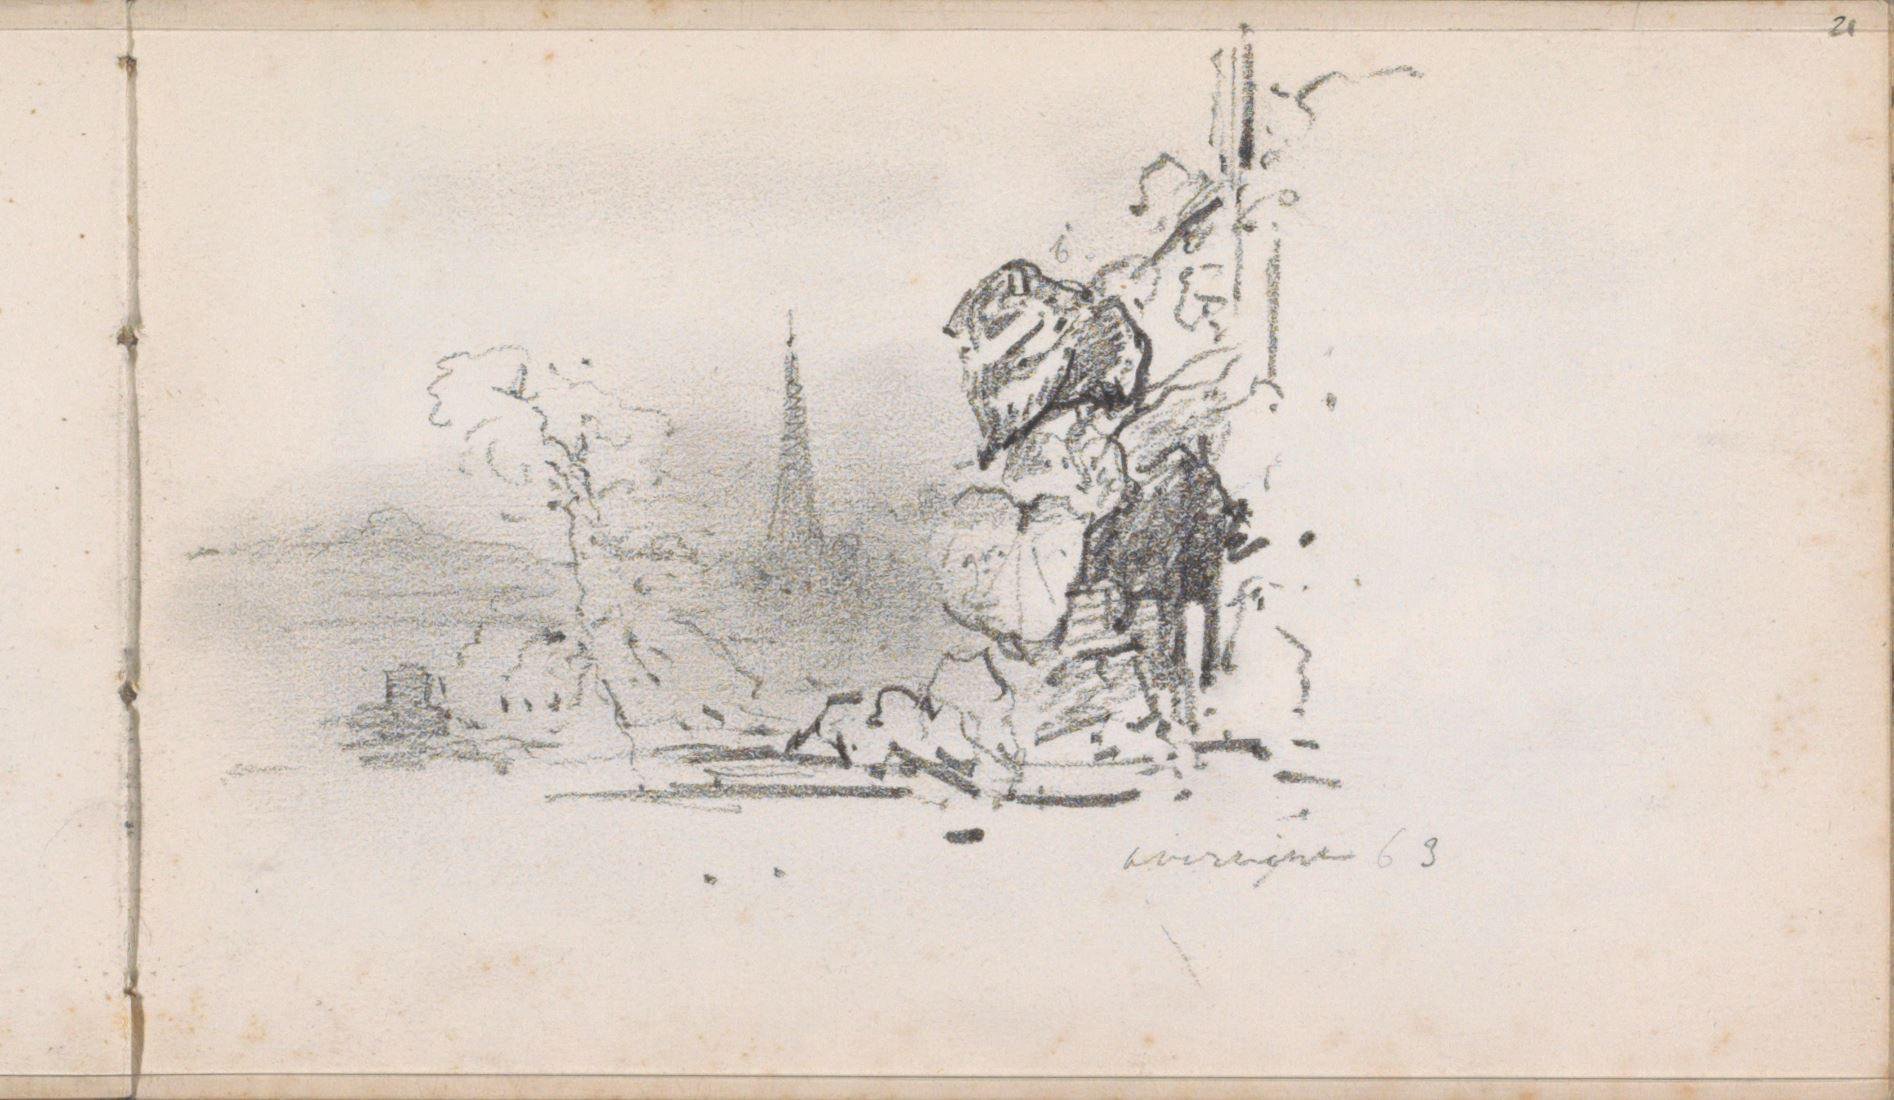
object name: sketchbook leaf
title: Landschap met bomen en een kerktoren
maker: maria vos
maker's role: draughtsman, painter, print maker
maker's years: 1824-1906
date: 1863-1864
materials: paper, pencil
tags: city-view, and landscape with man-made constructions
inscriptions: date and inscription: ‘overzicht 63’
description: Blad 21 recto uit een schetsboek met 41 bladen.